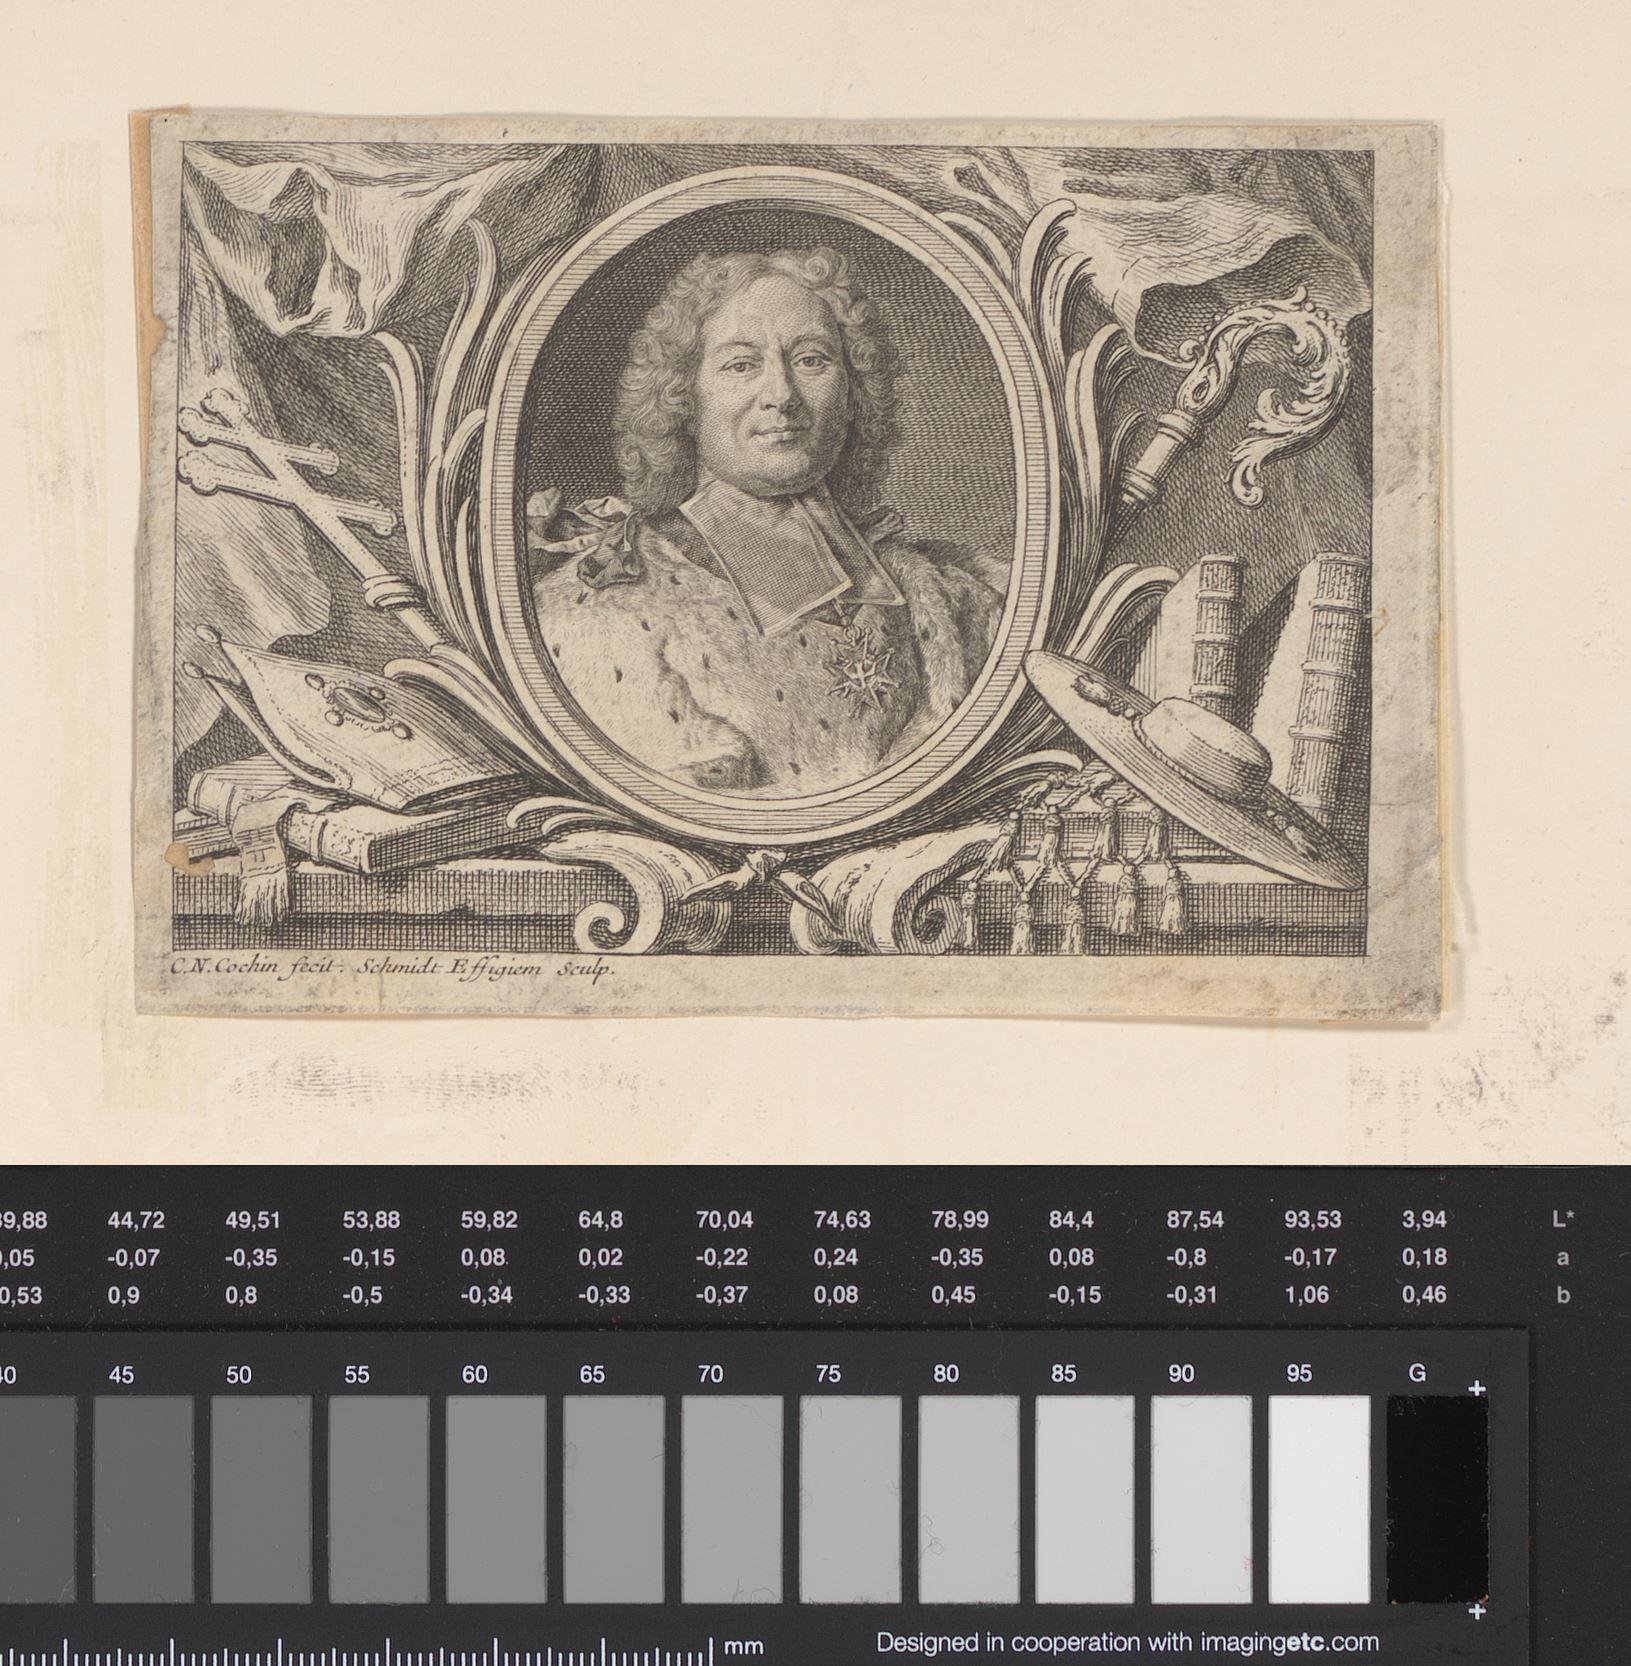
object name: album leaf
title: Portret van René François de Beauvau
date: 1738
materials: paper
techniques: engraving, etching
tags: archbishop, bishop, etc. (roman catholic), historical persons